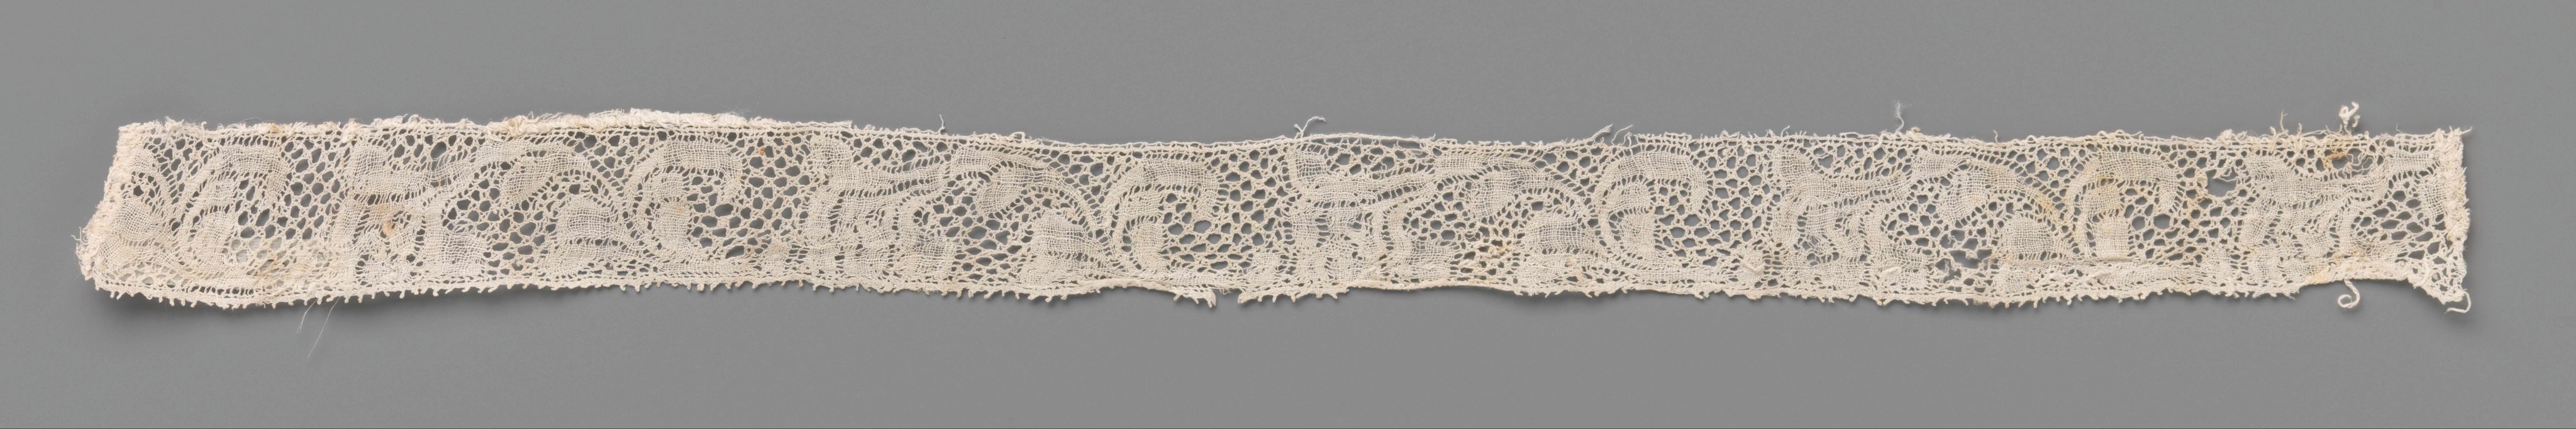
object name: strip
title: Strook kloskant met een eenzijdig gerichte s-vormige bloemstengel met een kelkbloem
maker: Anonymous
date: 1740-1760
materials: linen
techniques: lace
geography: southern netherlands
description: Strook naturekleurige kloskant, Binche-kant. Het zich herhalende patroon bestaat uit een eenzijdig gerichte s-vormige bloemstengel met een kelkbloem. De motieven zijn met elkaar verbonden door een traliegrond, een vijfgaatjesgrond. De motieven zijn gemaakt in linnenslag met opengewerkte randjes. Boven- en onderzijde van de strook zijn recht afgewerkt, waarbij de onderzijde is voorzien van picots.